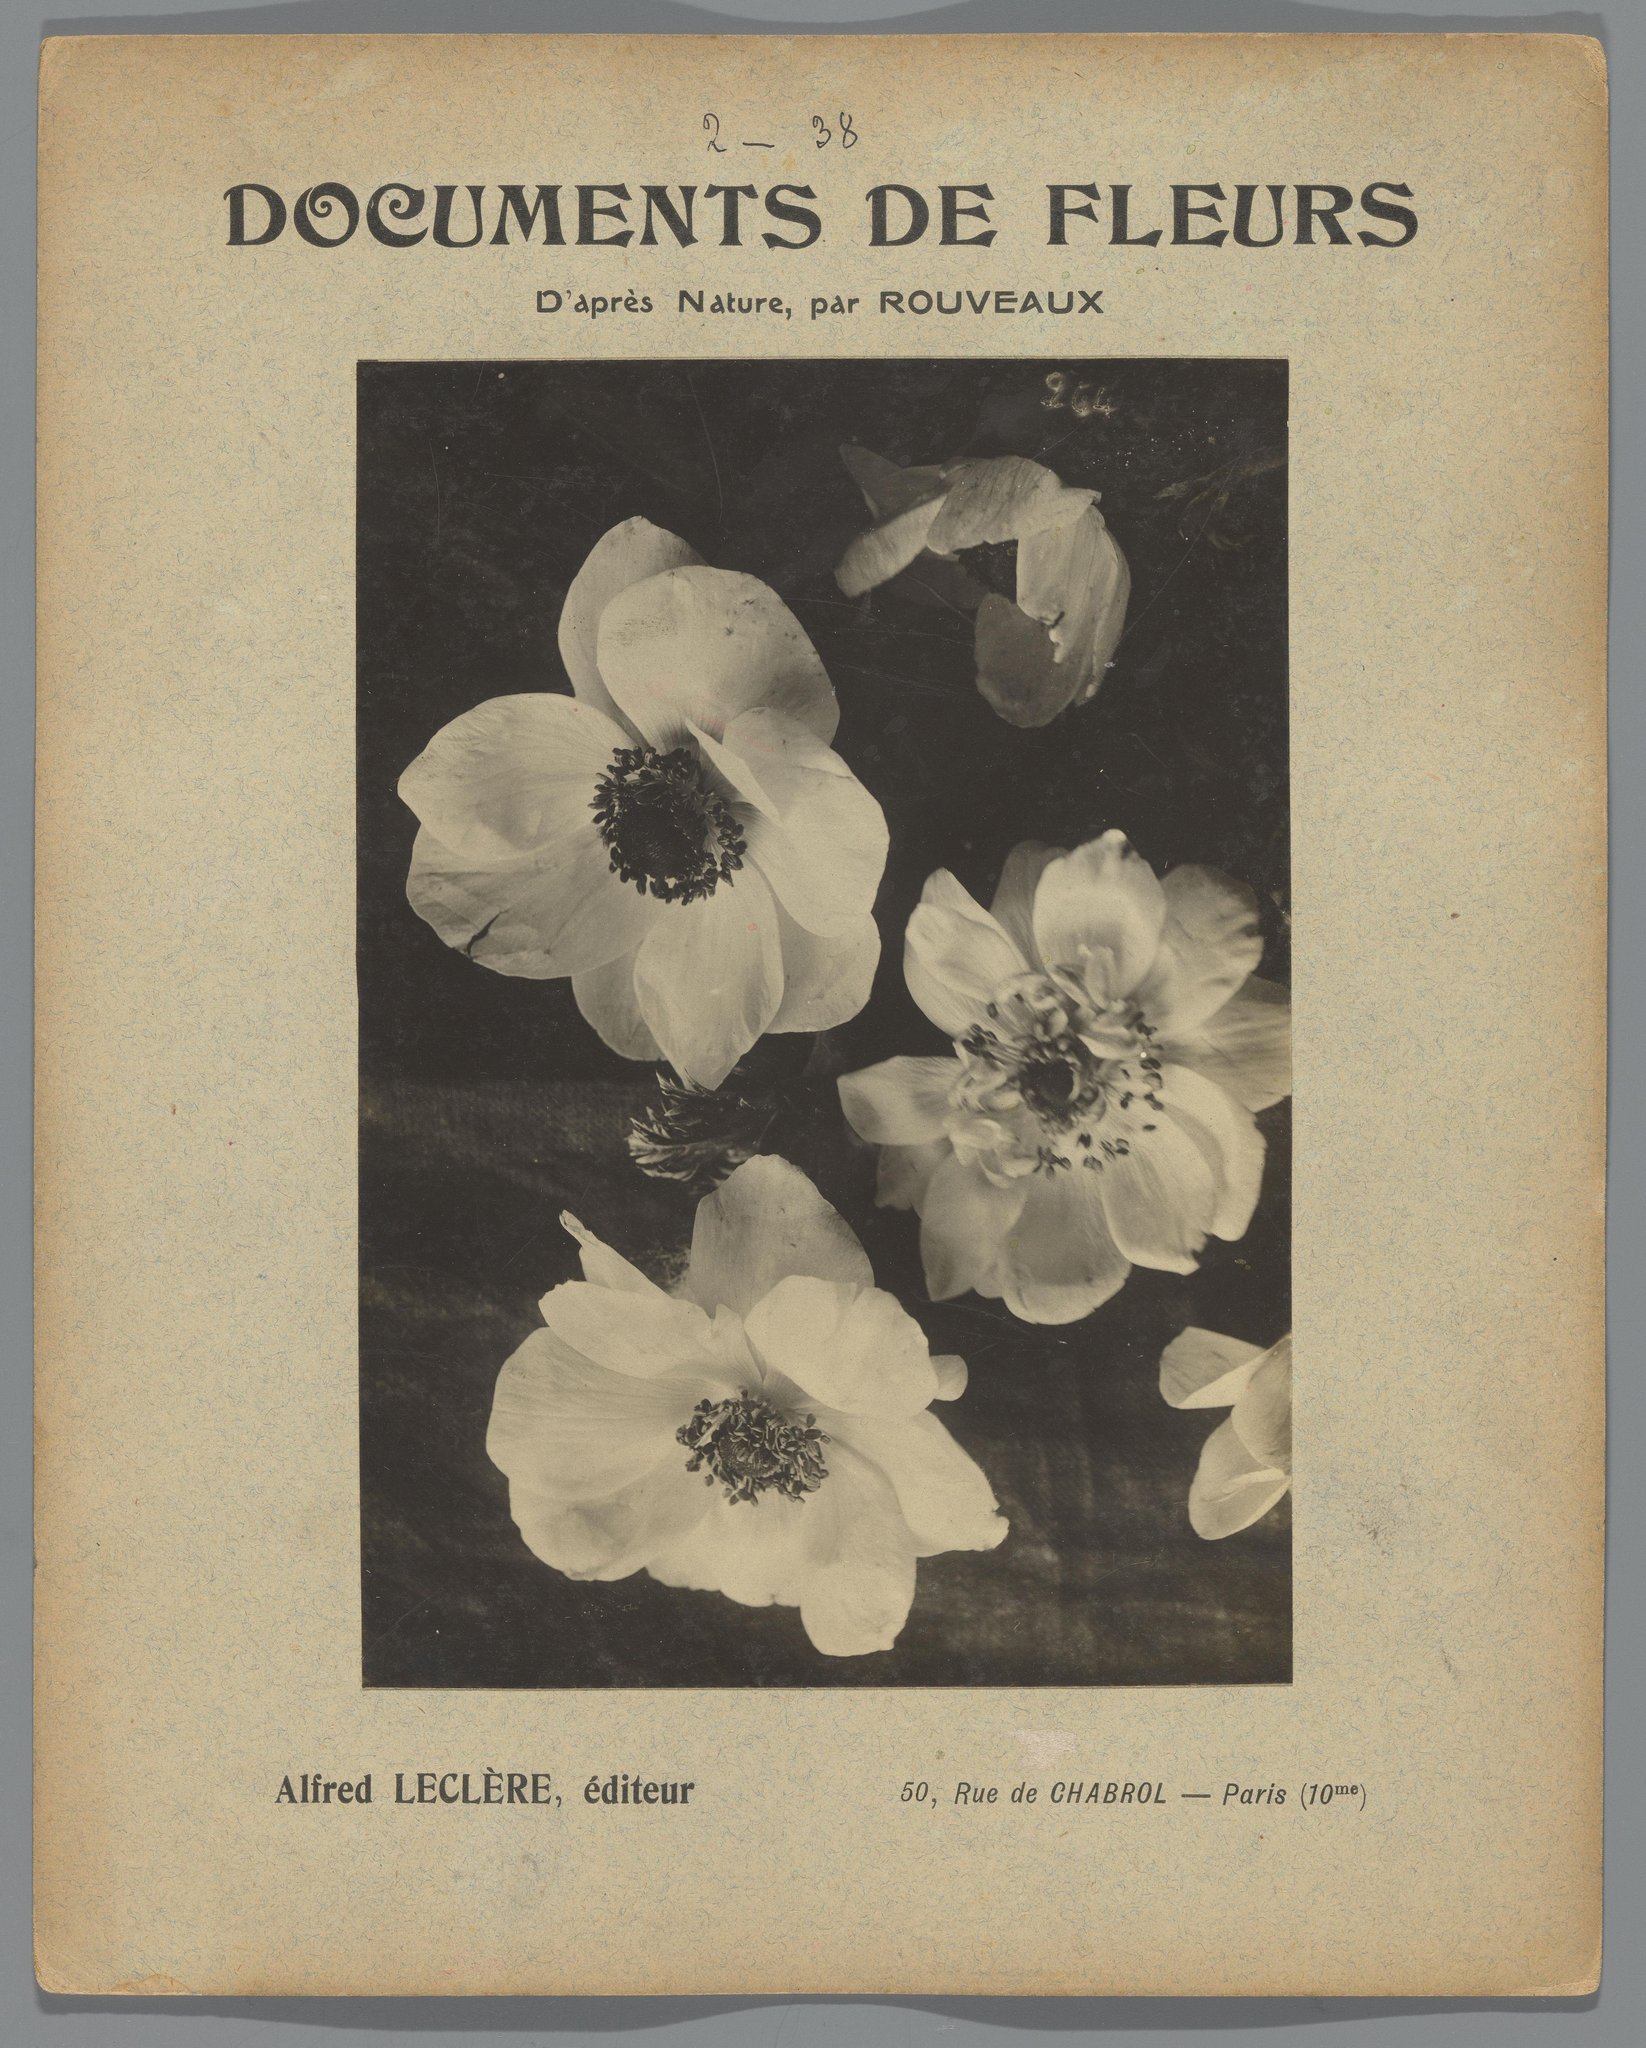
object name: photograph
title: Bloemstudie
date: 1895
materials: photographic support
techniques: gelatin silver print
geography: france